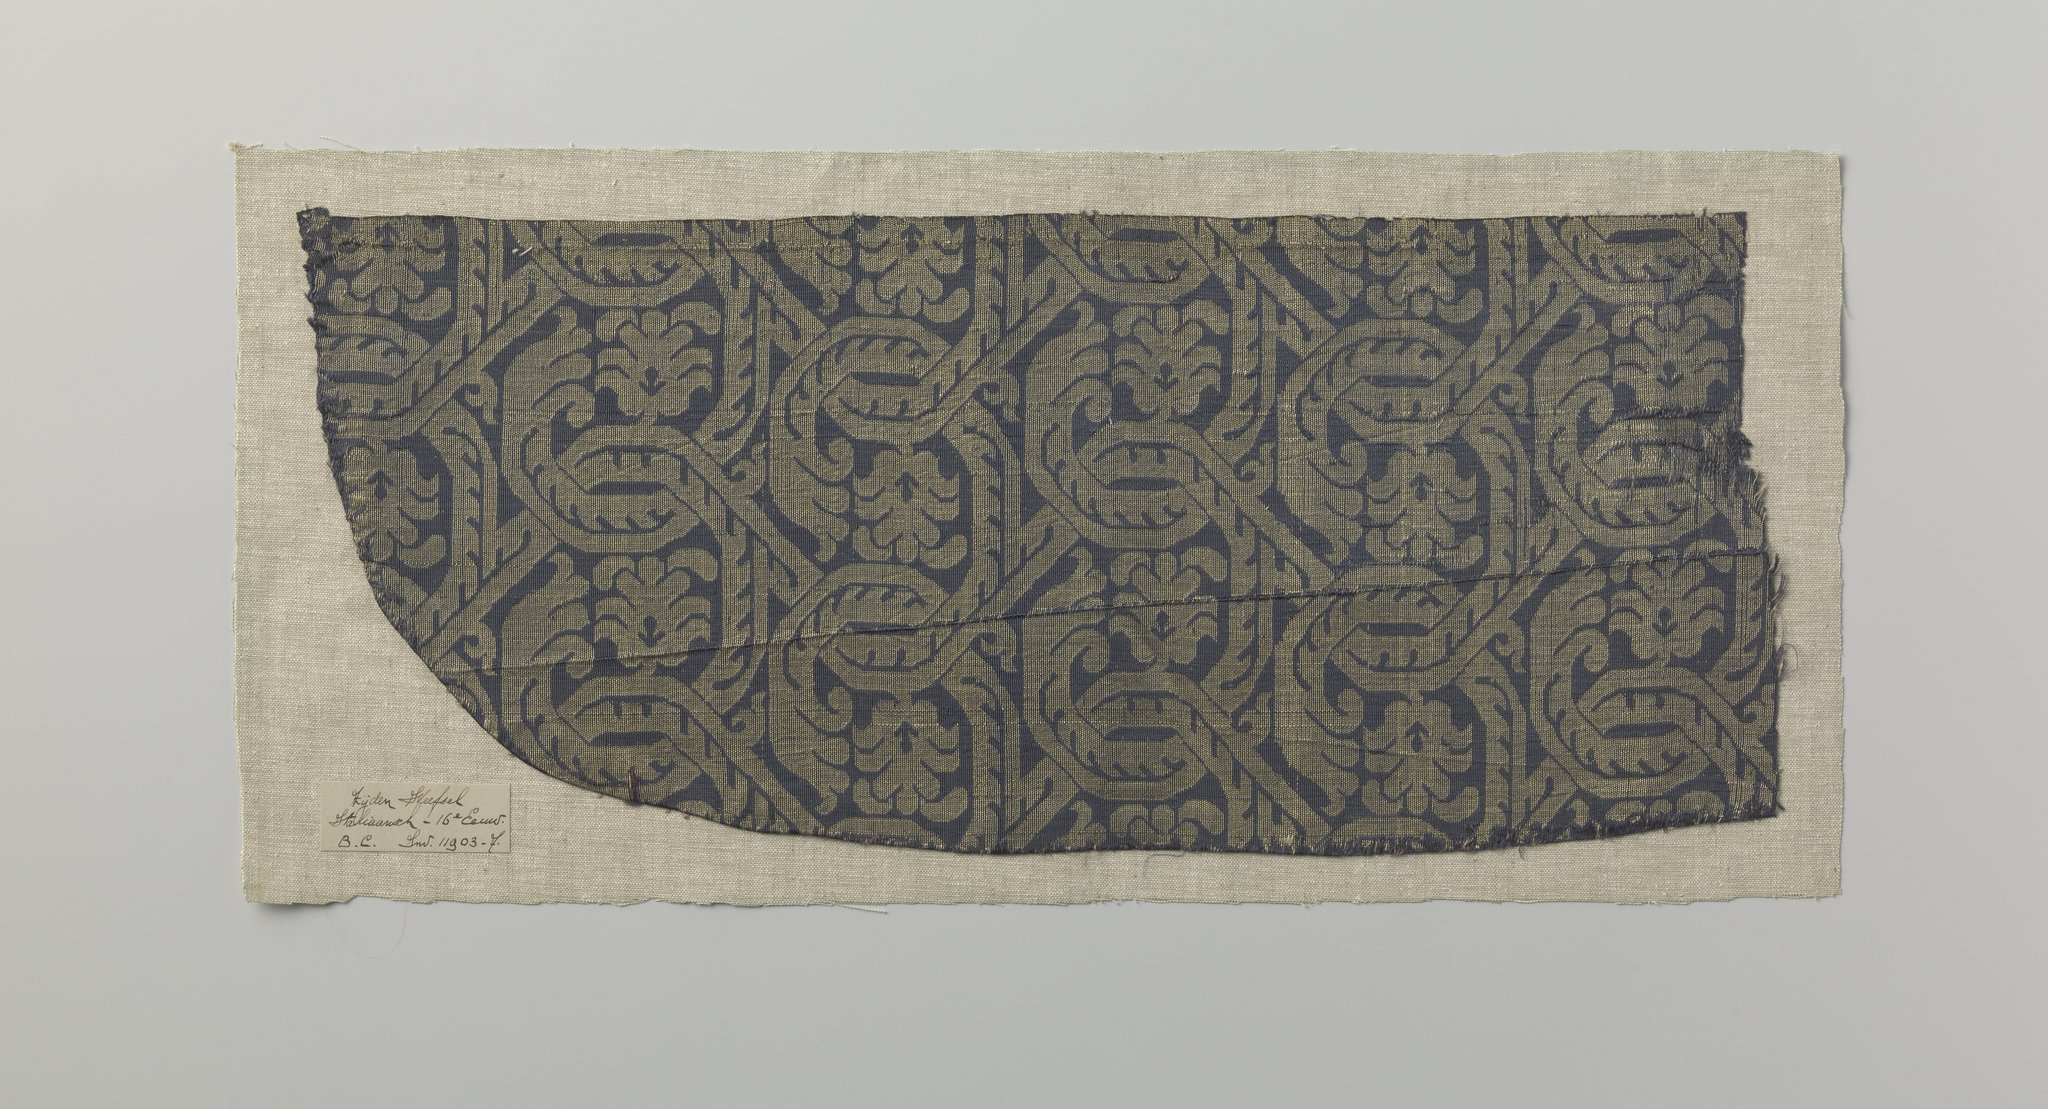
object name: silk textile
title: Fragment blauw zijdeweefsel met gestileerde acanthusranken en palmetten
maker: Anonymous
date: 1500-1599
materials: metal thread, silk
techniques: double-sided binding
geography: italy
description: Fragment blauwe zijde met patroon in goud van zigzag ranken met dwarsgeplaatste palmetten en grote in elkaar hakende krullende zijranken.